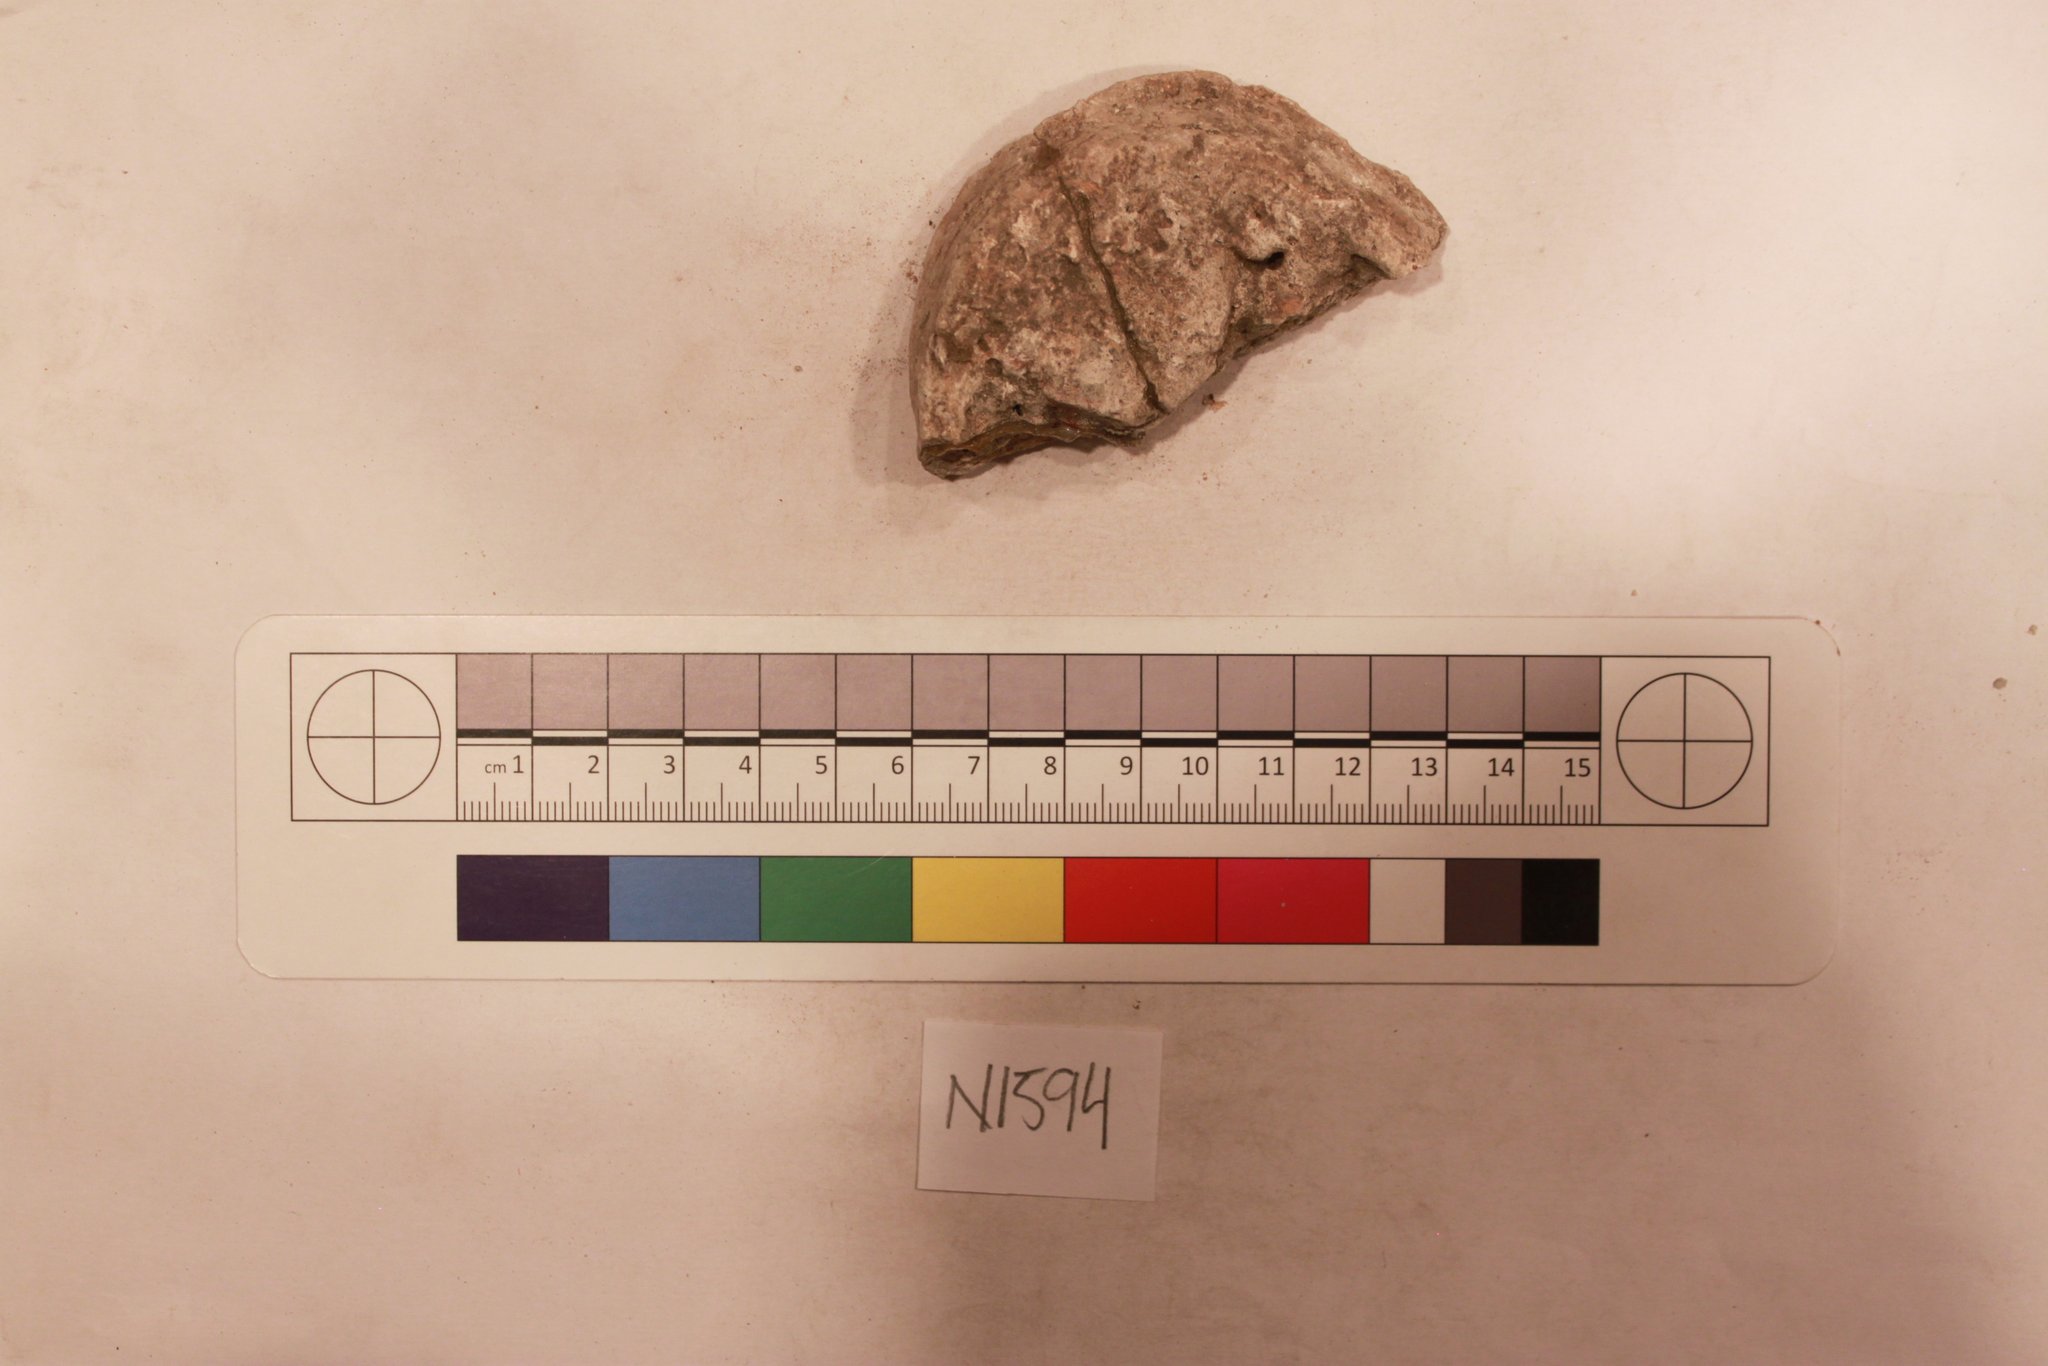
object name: fragment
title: Stucco Fragment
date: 701-1200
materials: plaster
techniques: carving, painting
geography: iran